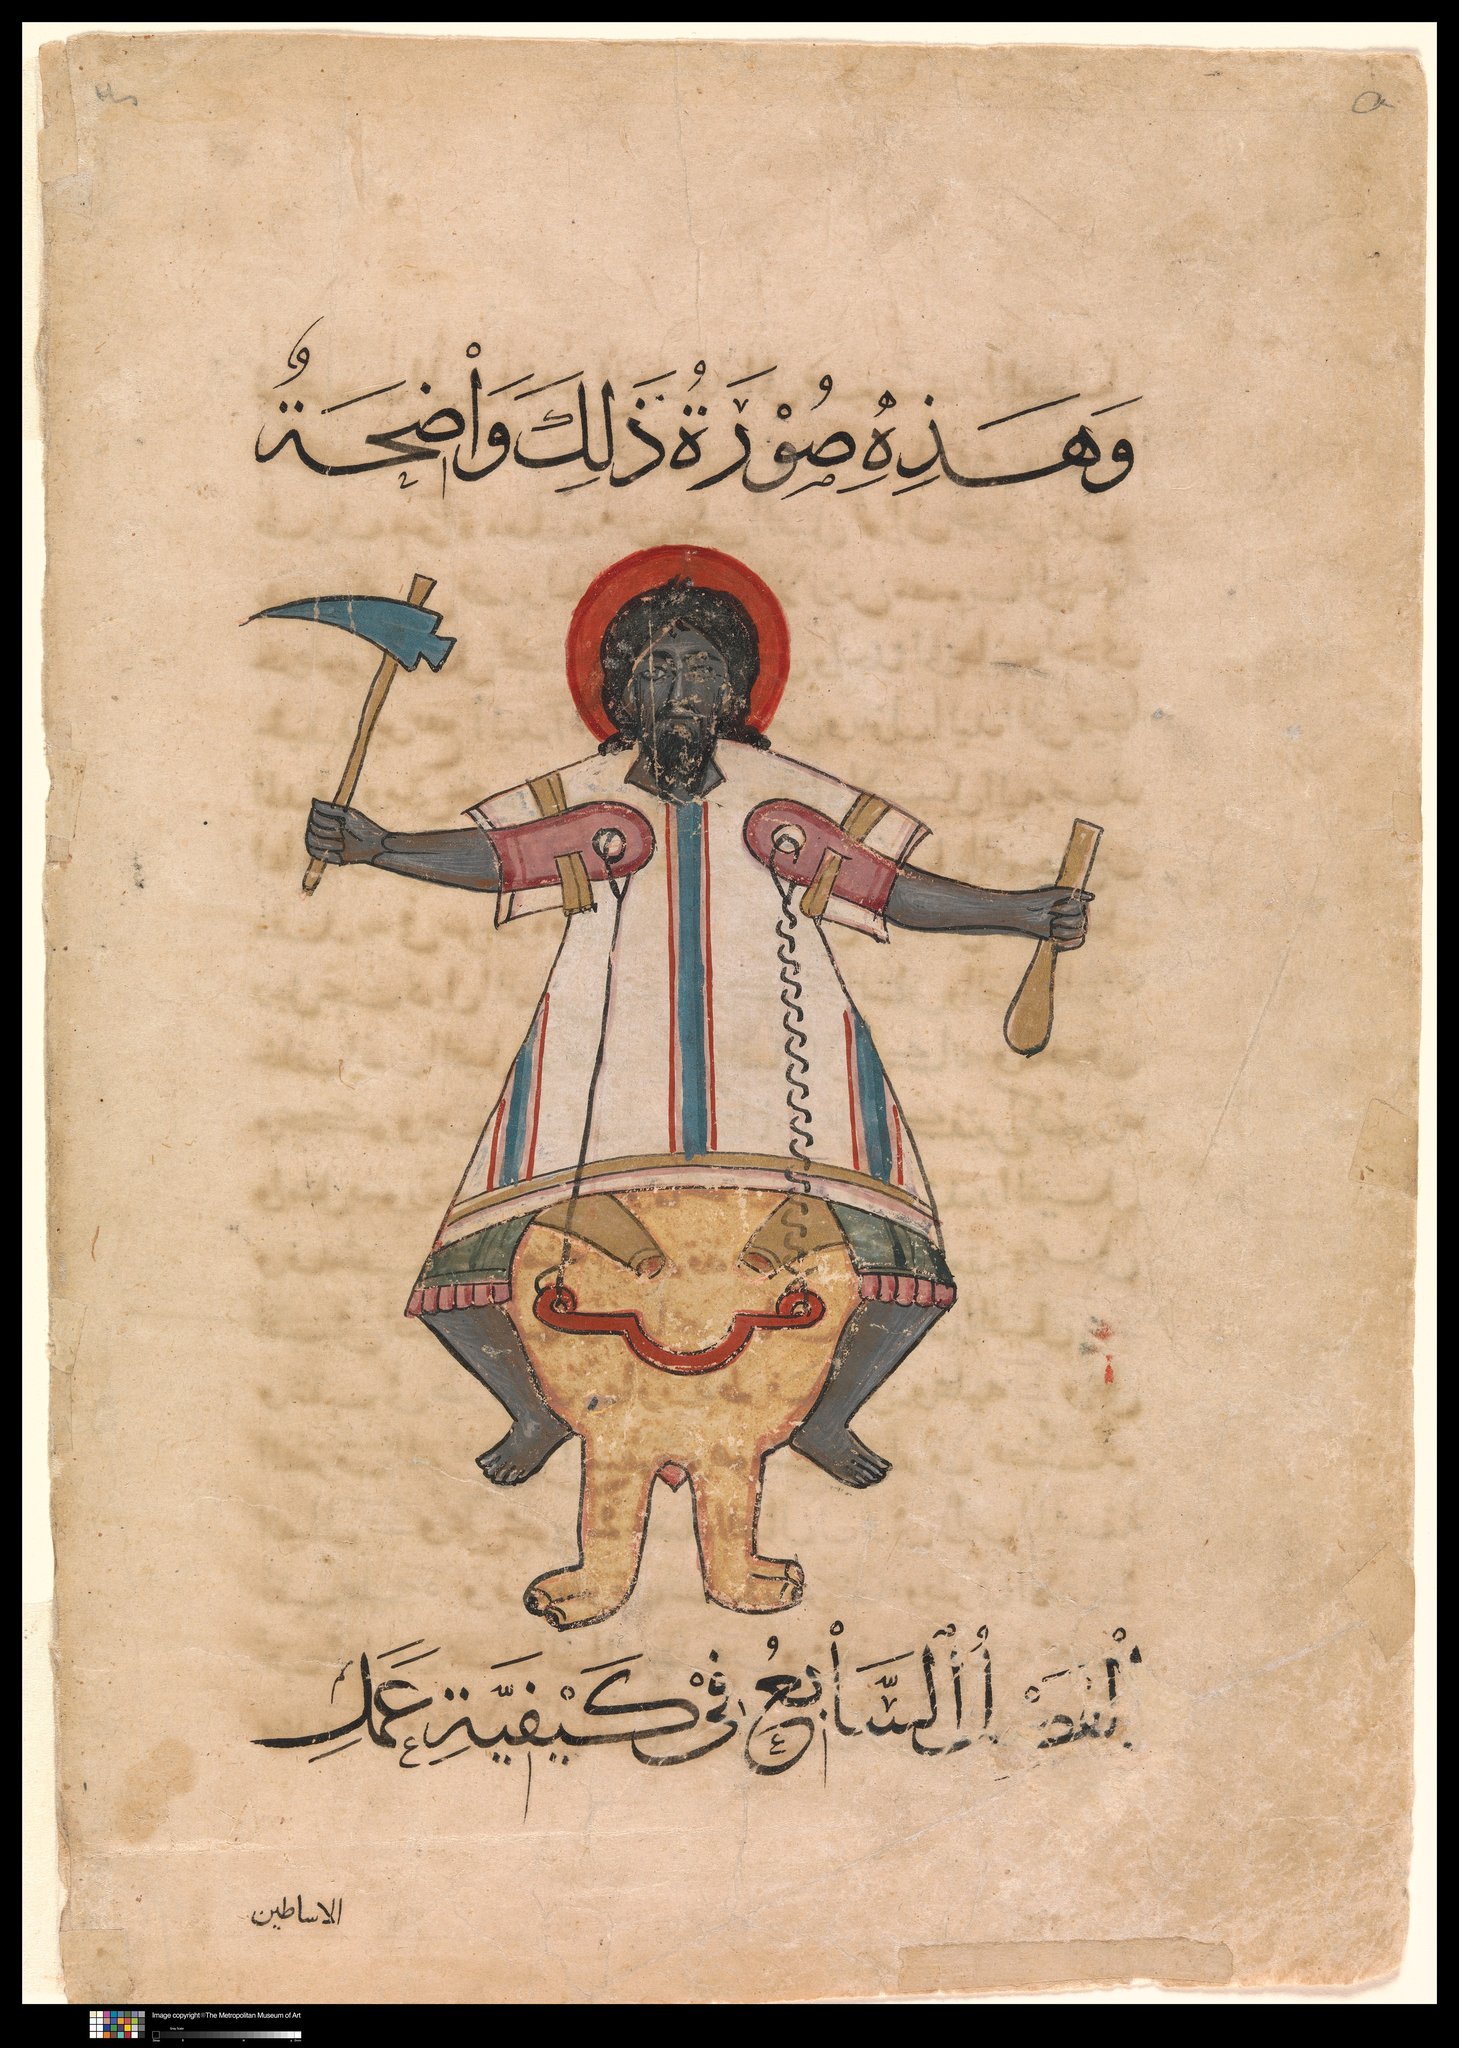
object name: folio from an illustrated manuscript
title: "Design for a Clock in the Form of an Elephant with an Indian Driver", Folio from a Book of the Knowledge of Ingenious Mechanical Devices by al-Jazari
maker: badi' al-zaman ibn al-razzaz al-jazari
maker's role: author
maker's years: 1136-1206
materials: gold, ink, paper, watercolor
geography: syria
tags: human figures,weapons